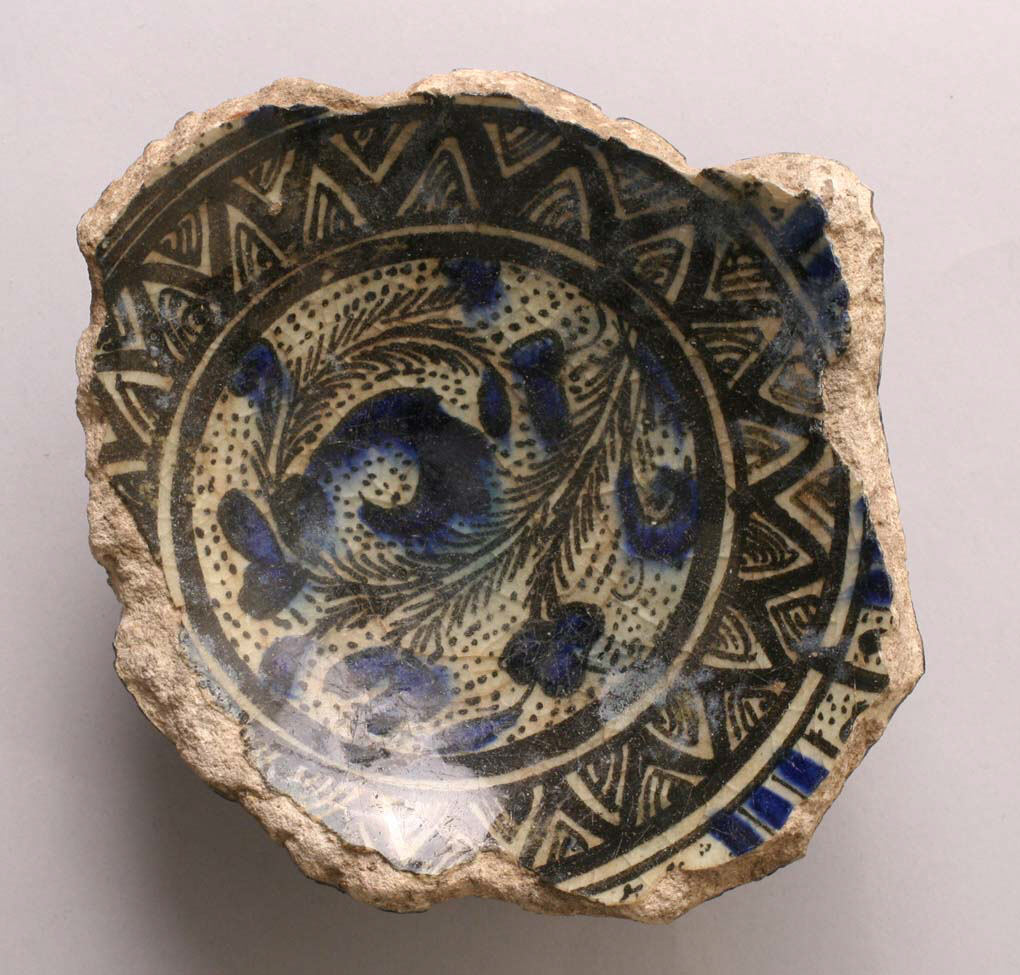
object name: fragment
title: Fragment of a Bowl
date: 1301-1400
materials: glaze, stonepaste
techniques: underglaze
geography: egypt